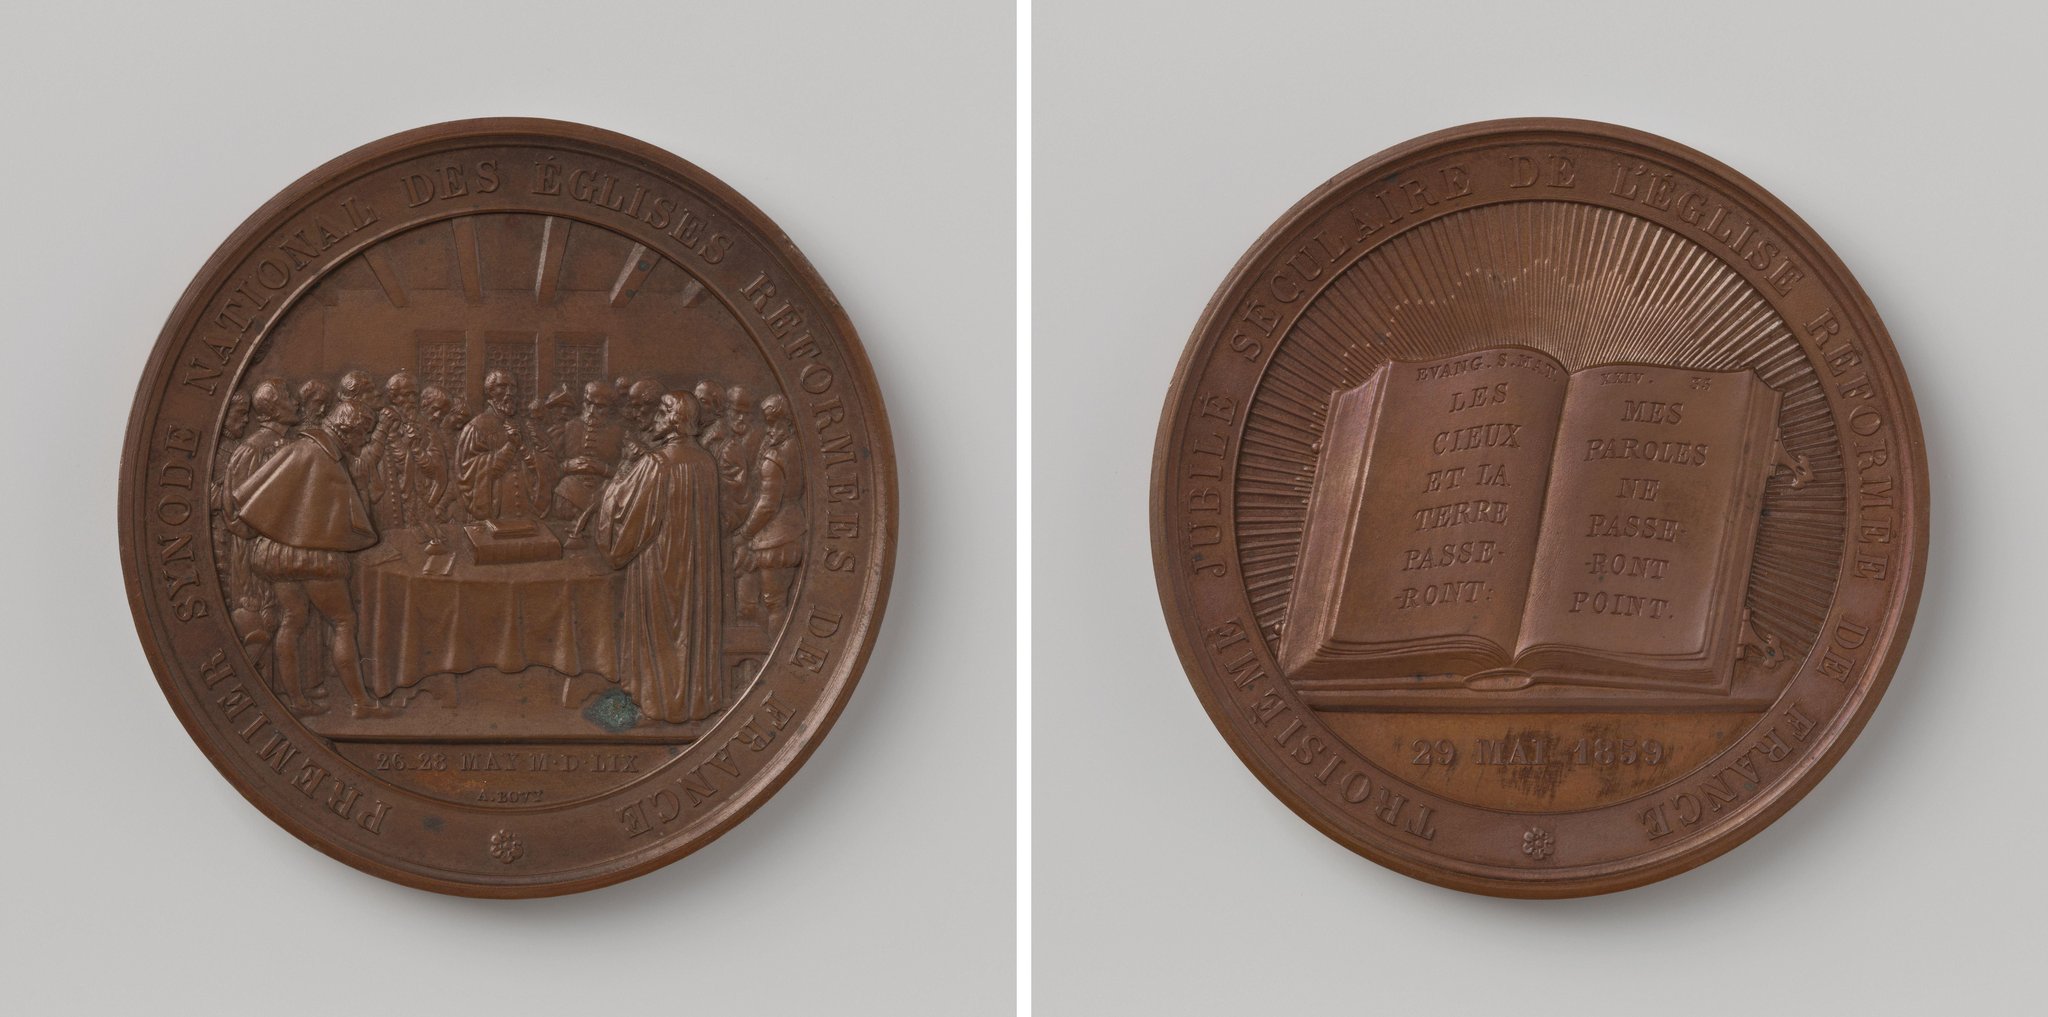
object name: history medal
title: Derde eeuwfeest van de Hervormde kerk in Frankrijk een eerste Nationale Synode van de Hervormde kerken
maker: jean françois antoine bovy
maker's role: medailleur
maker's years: 1795-1877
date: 1859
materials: copper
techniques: striking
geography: paris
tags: france